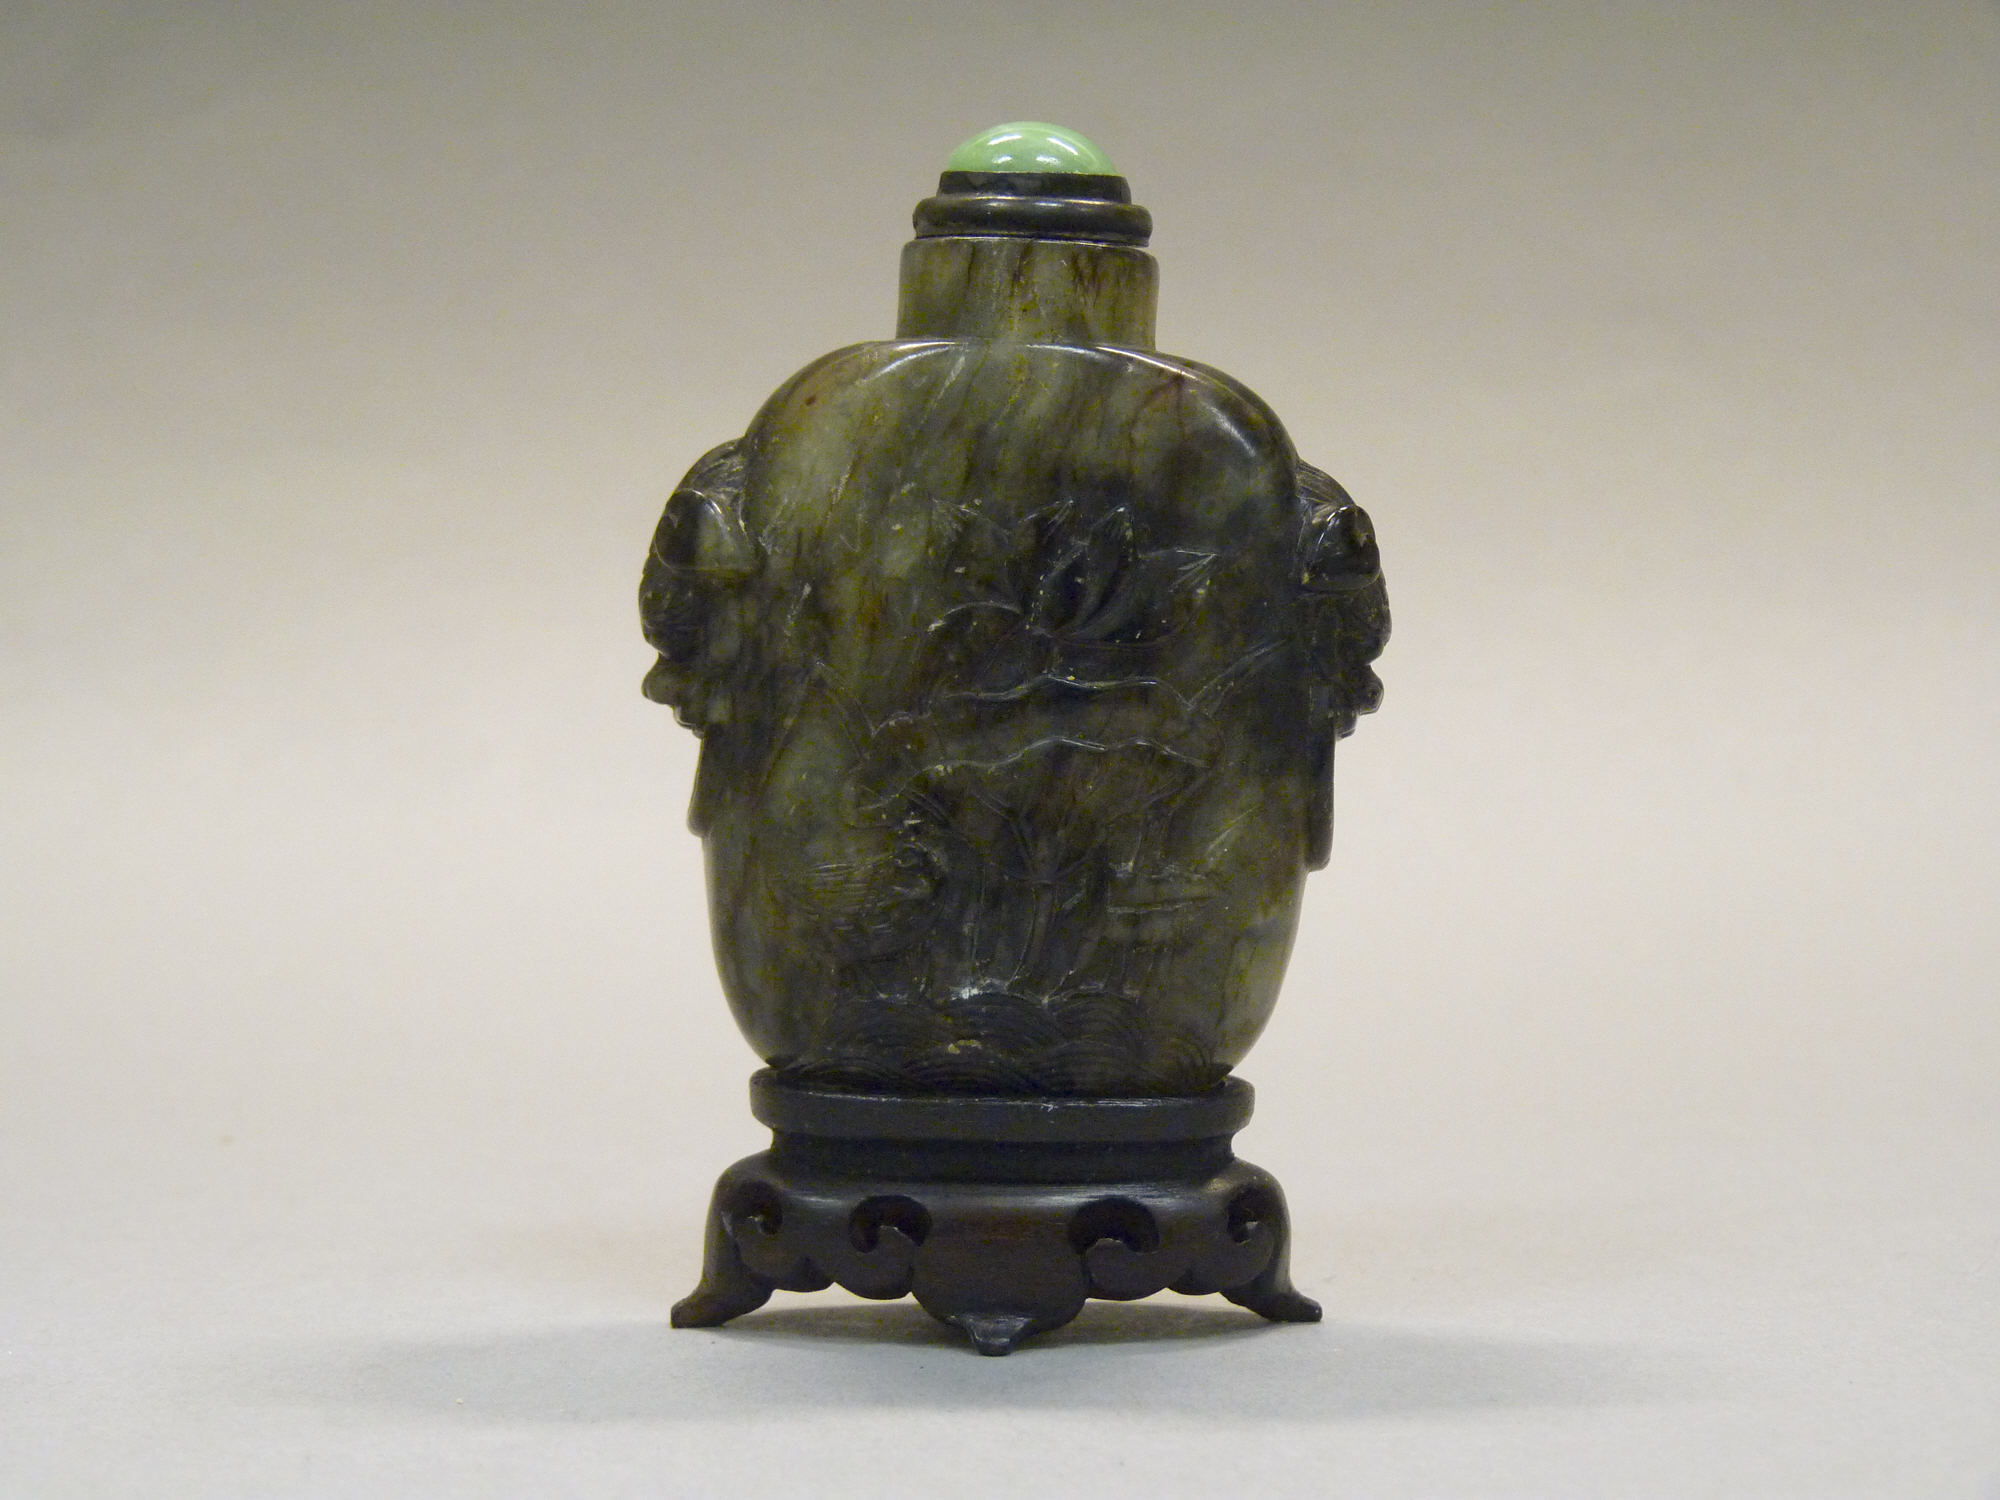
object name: snuff bottle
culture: chinese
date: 1736-1795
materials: jade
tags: lotuses